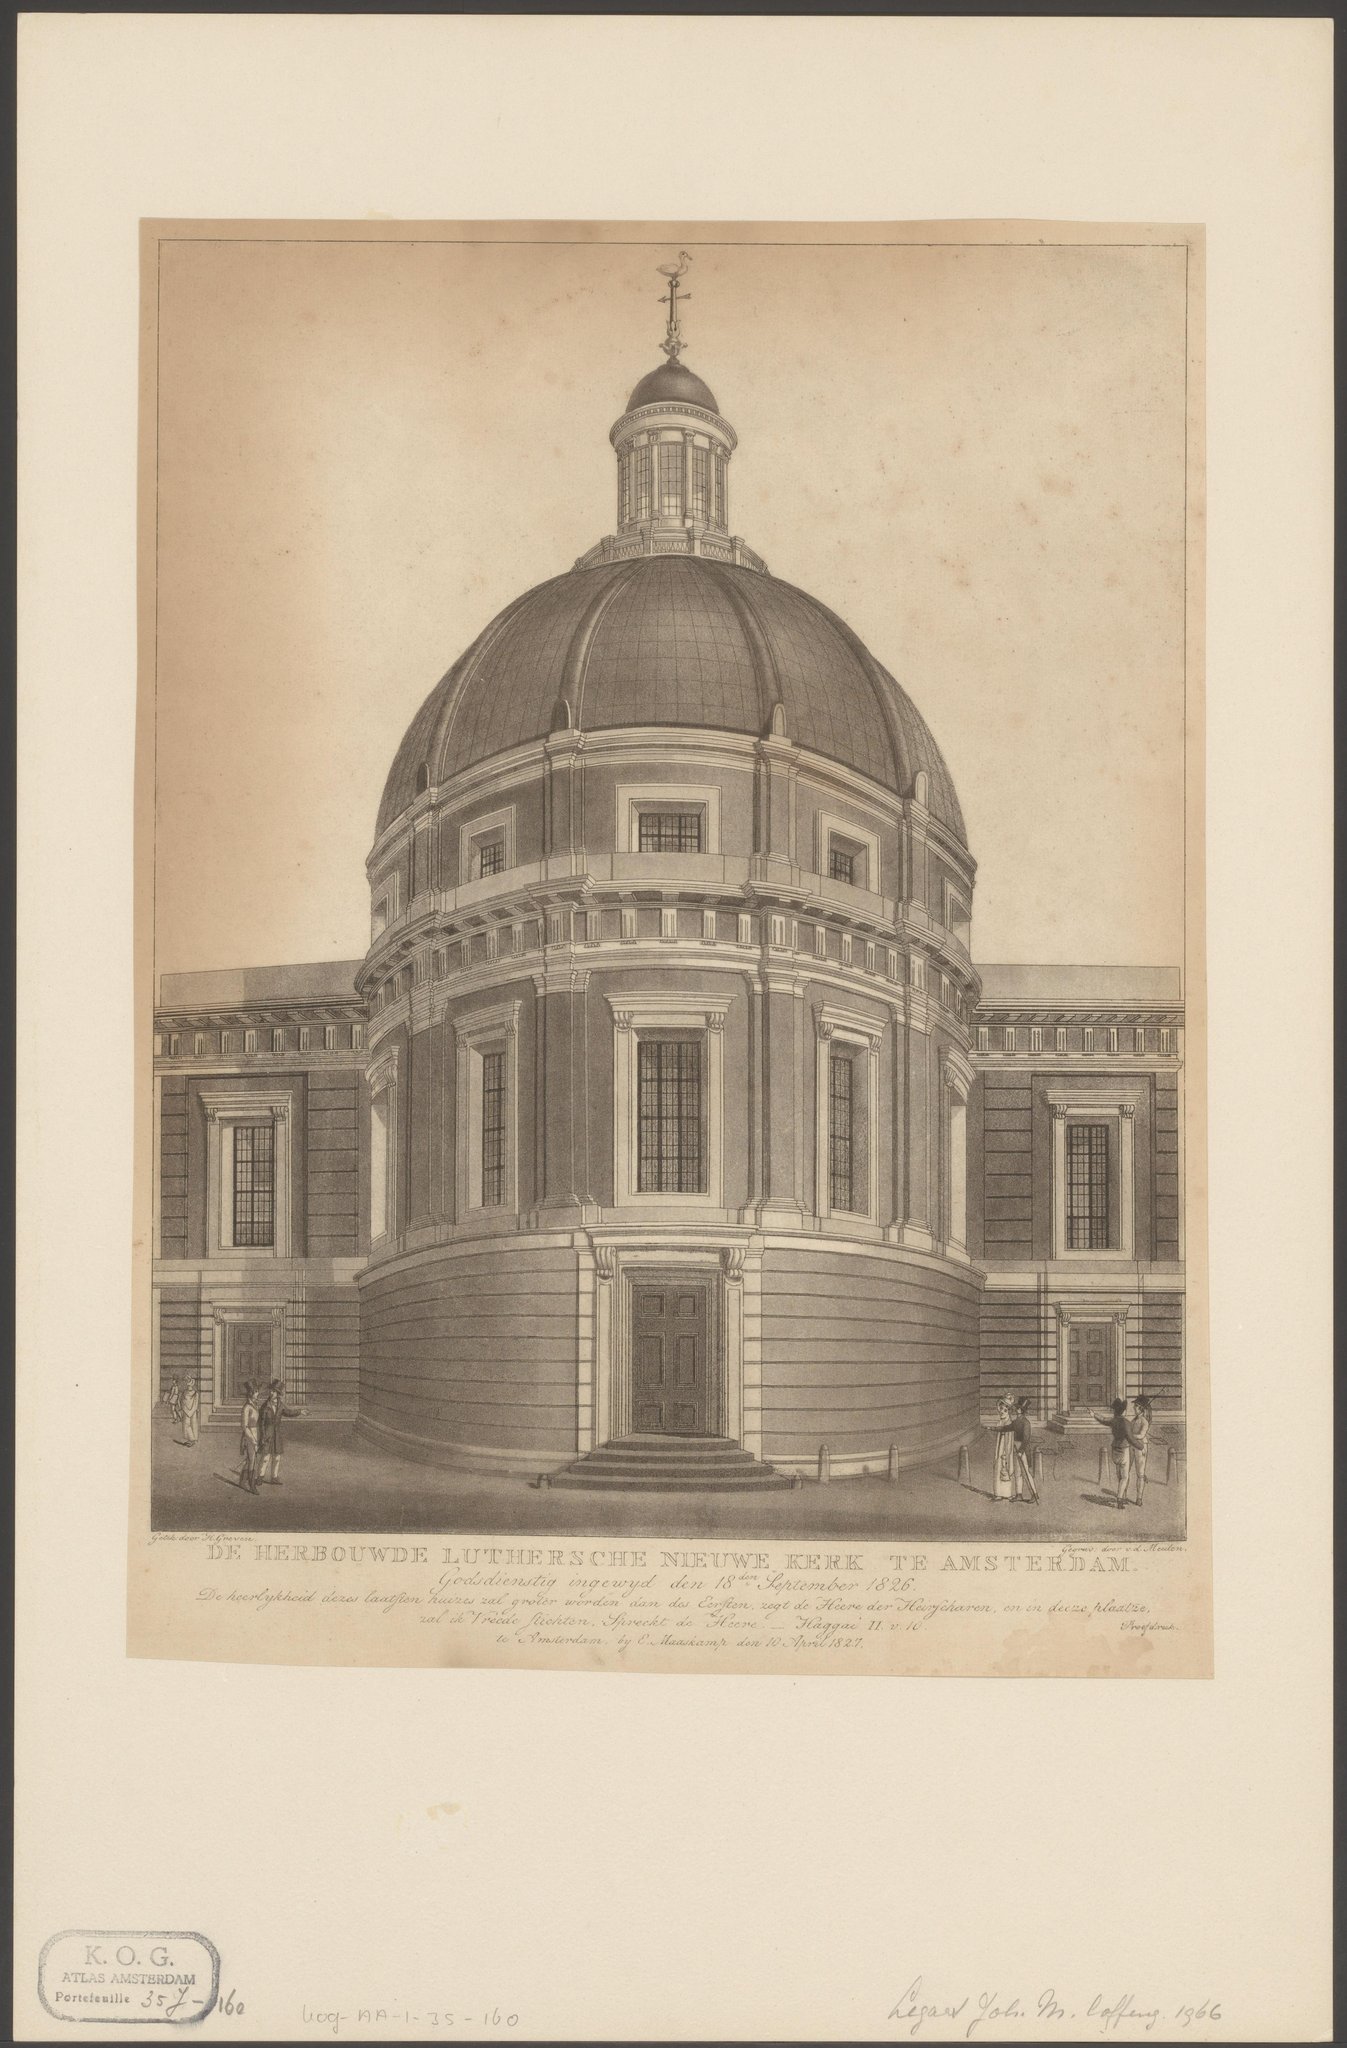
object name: print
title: Gezicht op de herbouwde Nieuwe Lutherse Kerk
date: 1827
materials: paper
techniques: aquatint, etching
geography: amsterdam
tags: church (exterior)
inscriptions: collector's mark: Lugt 1641b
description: Uitgegeven ter gelegenheid van de herbouw van de Nieuwe Lutherse Kerk. Onderwerpsrubriek binnen de Atlas Amsterdam: Kerkwezen: Ev. Lutherse Gemeente: Ronde Luthersche Kerk na de herbouwing.